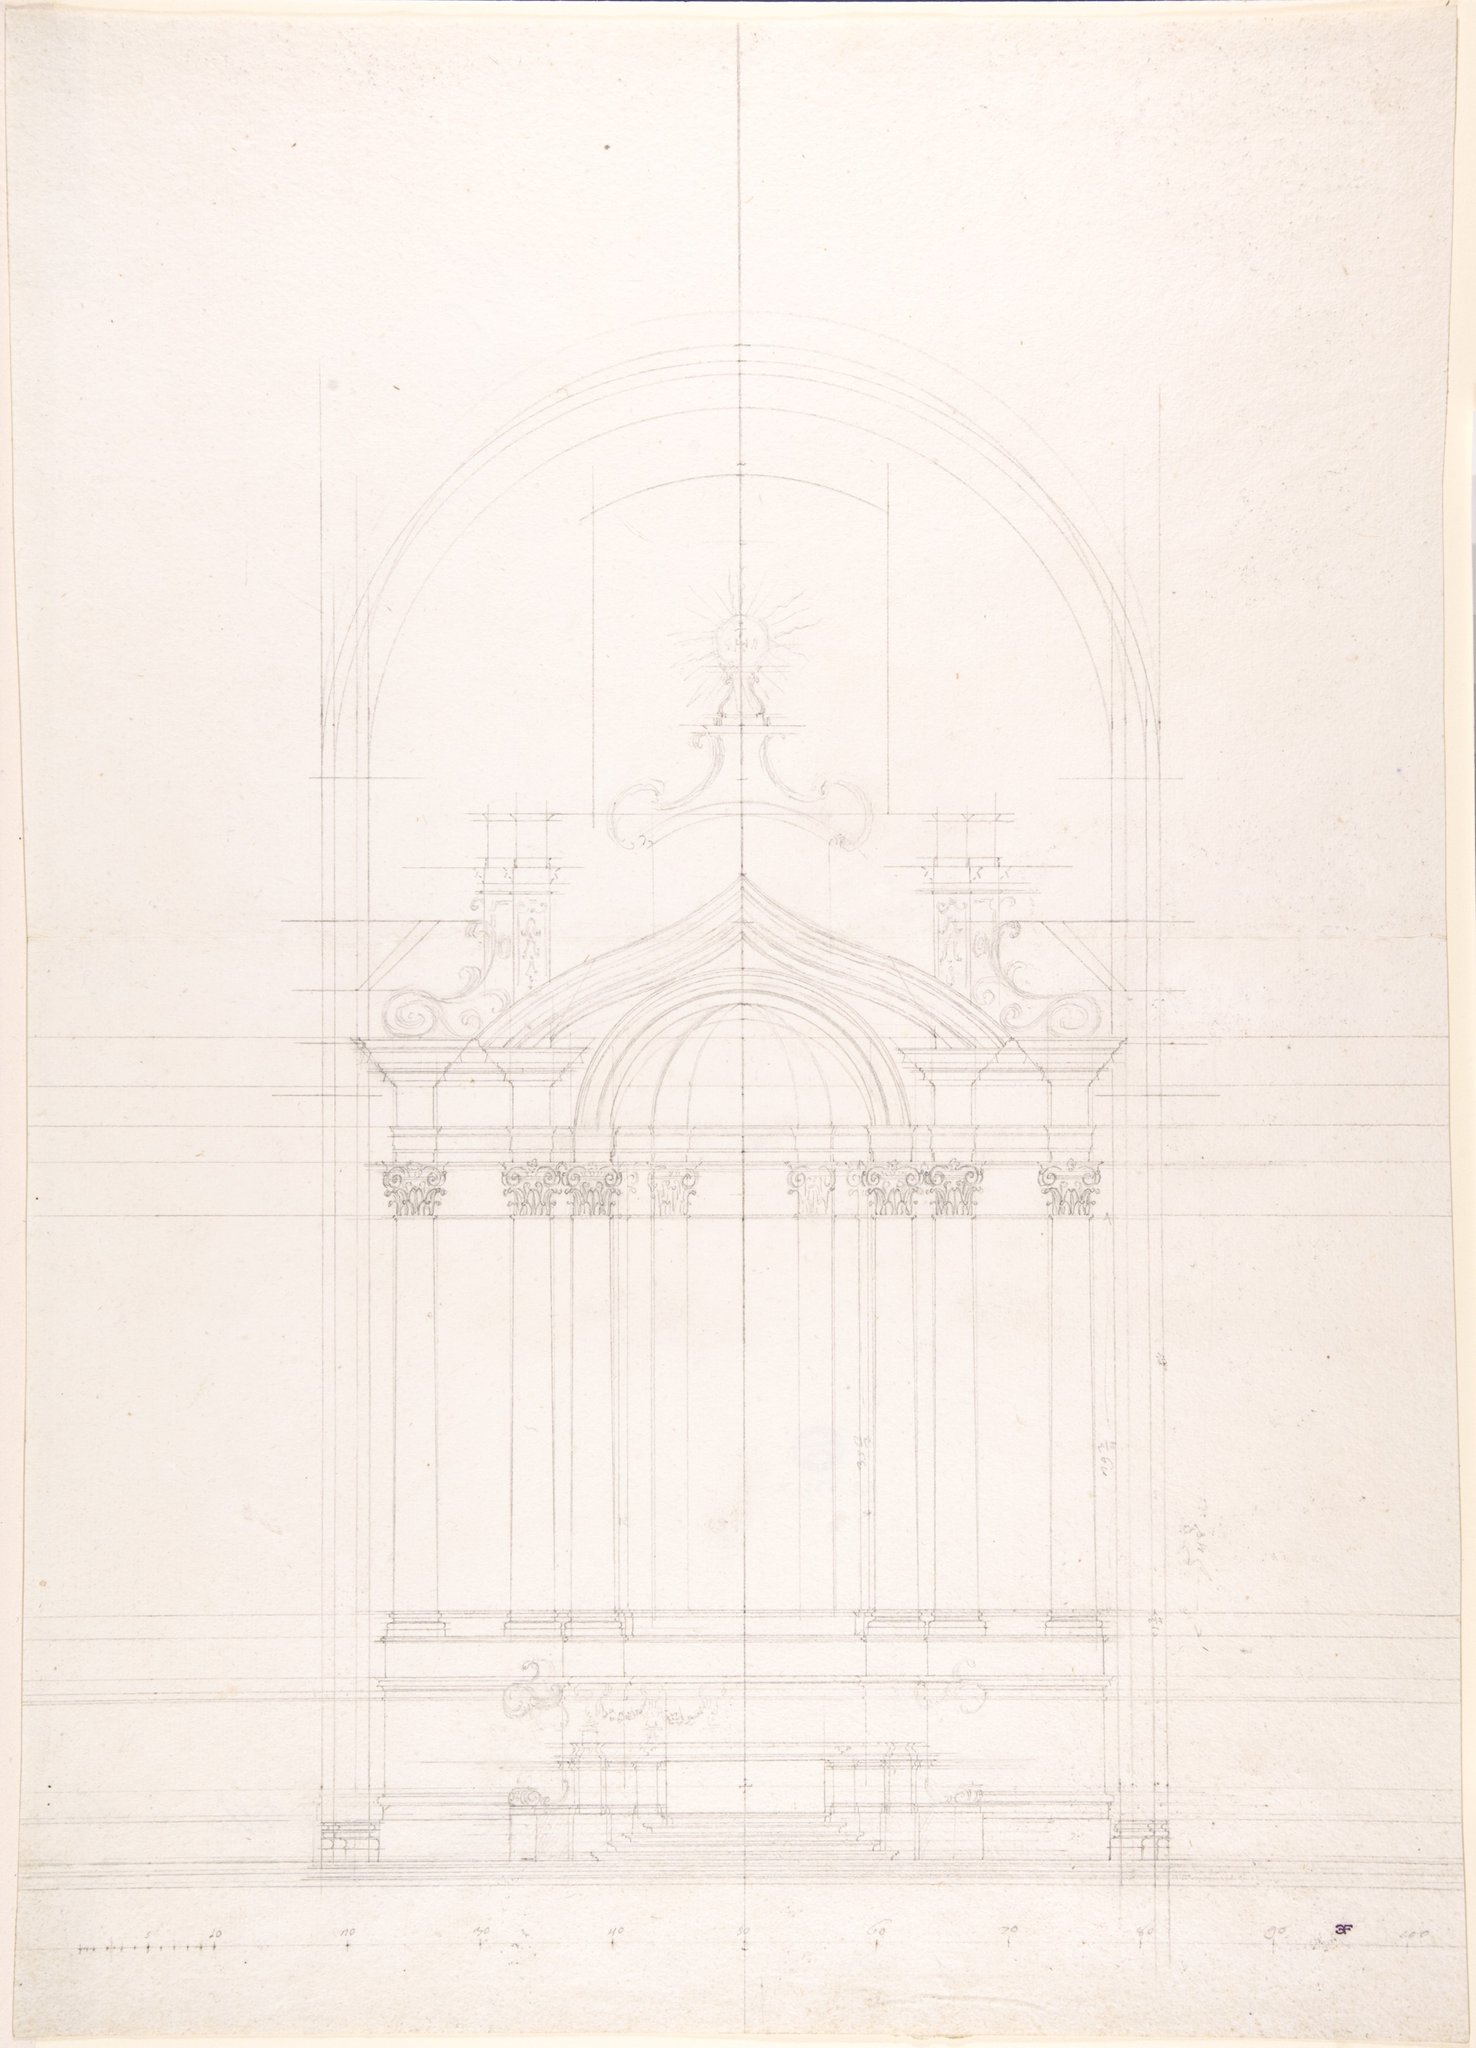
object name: drawing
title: Design for the high altar of the Gesù Nuovo, Naples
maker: luigi vanvitelli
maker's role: artist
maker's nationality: italian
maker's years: 1700-1773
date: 1700-1773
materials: graphite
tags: architecture,altars